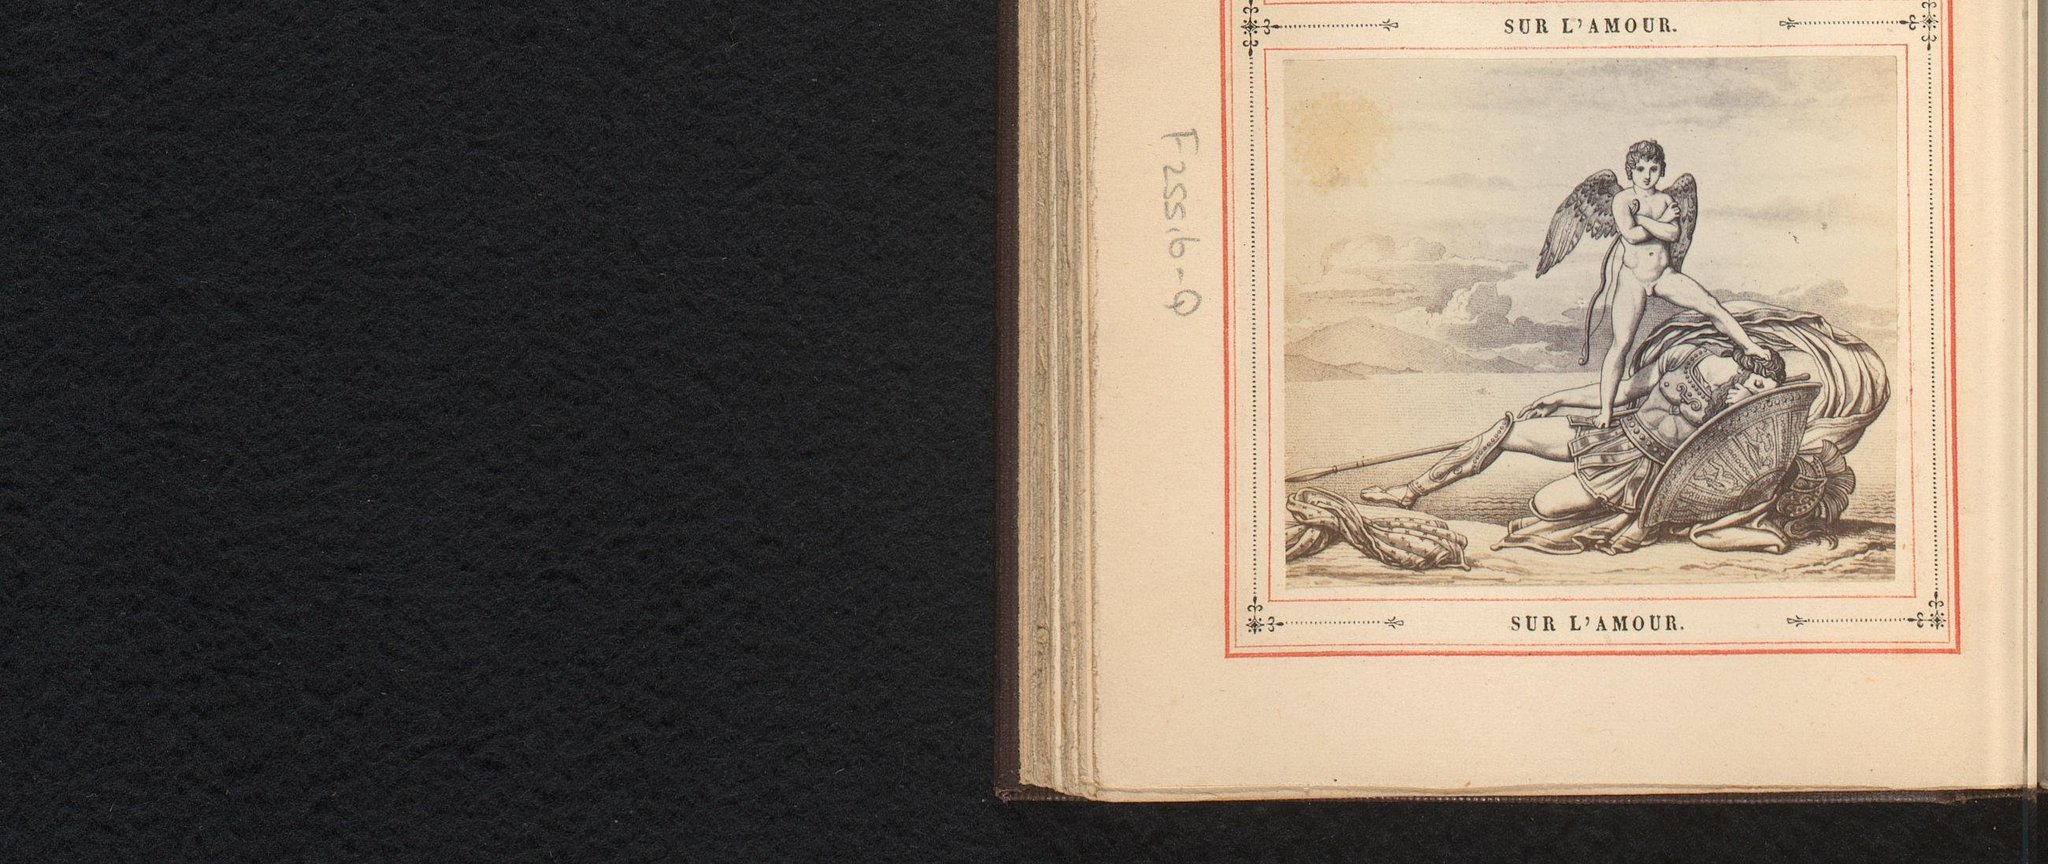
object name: photograph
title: Sur l'amour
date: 1859-1864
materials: paper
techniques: albumen print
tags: gods ~ classical mythology